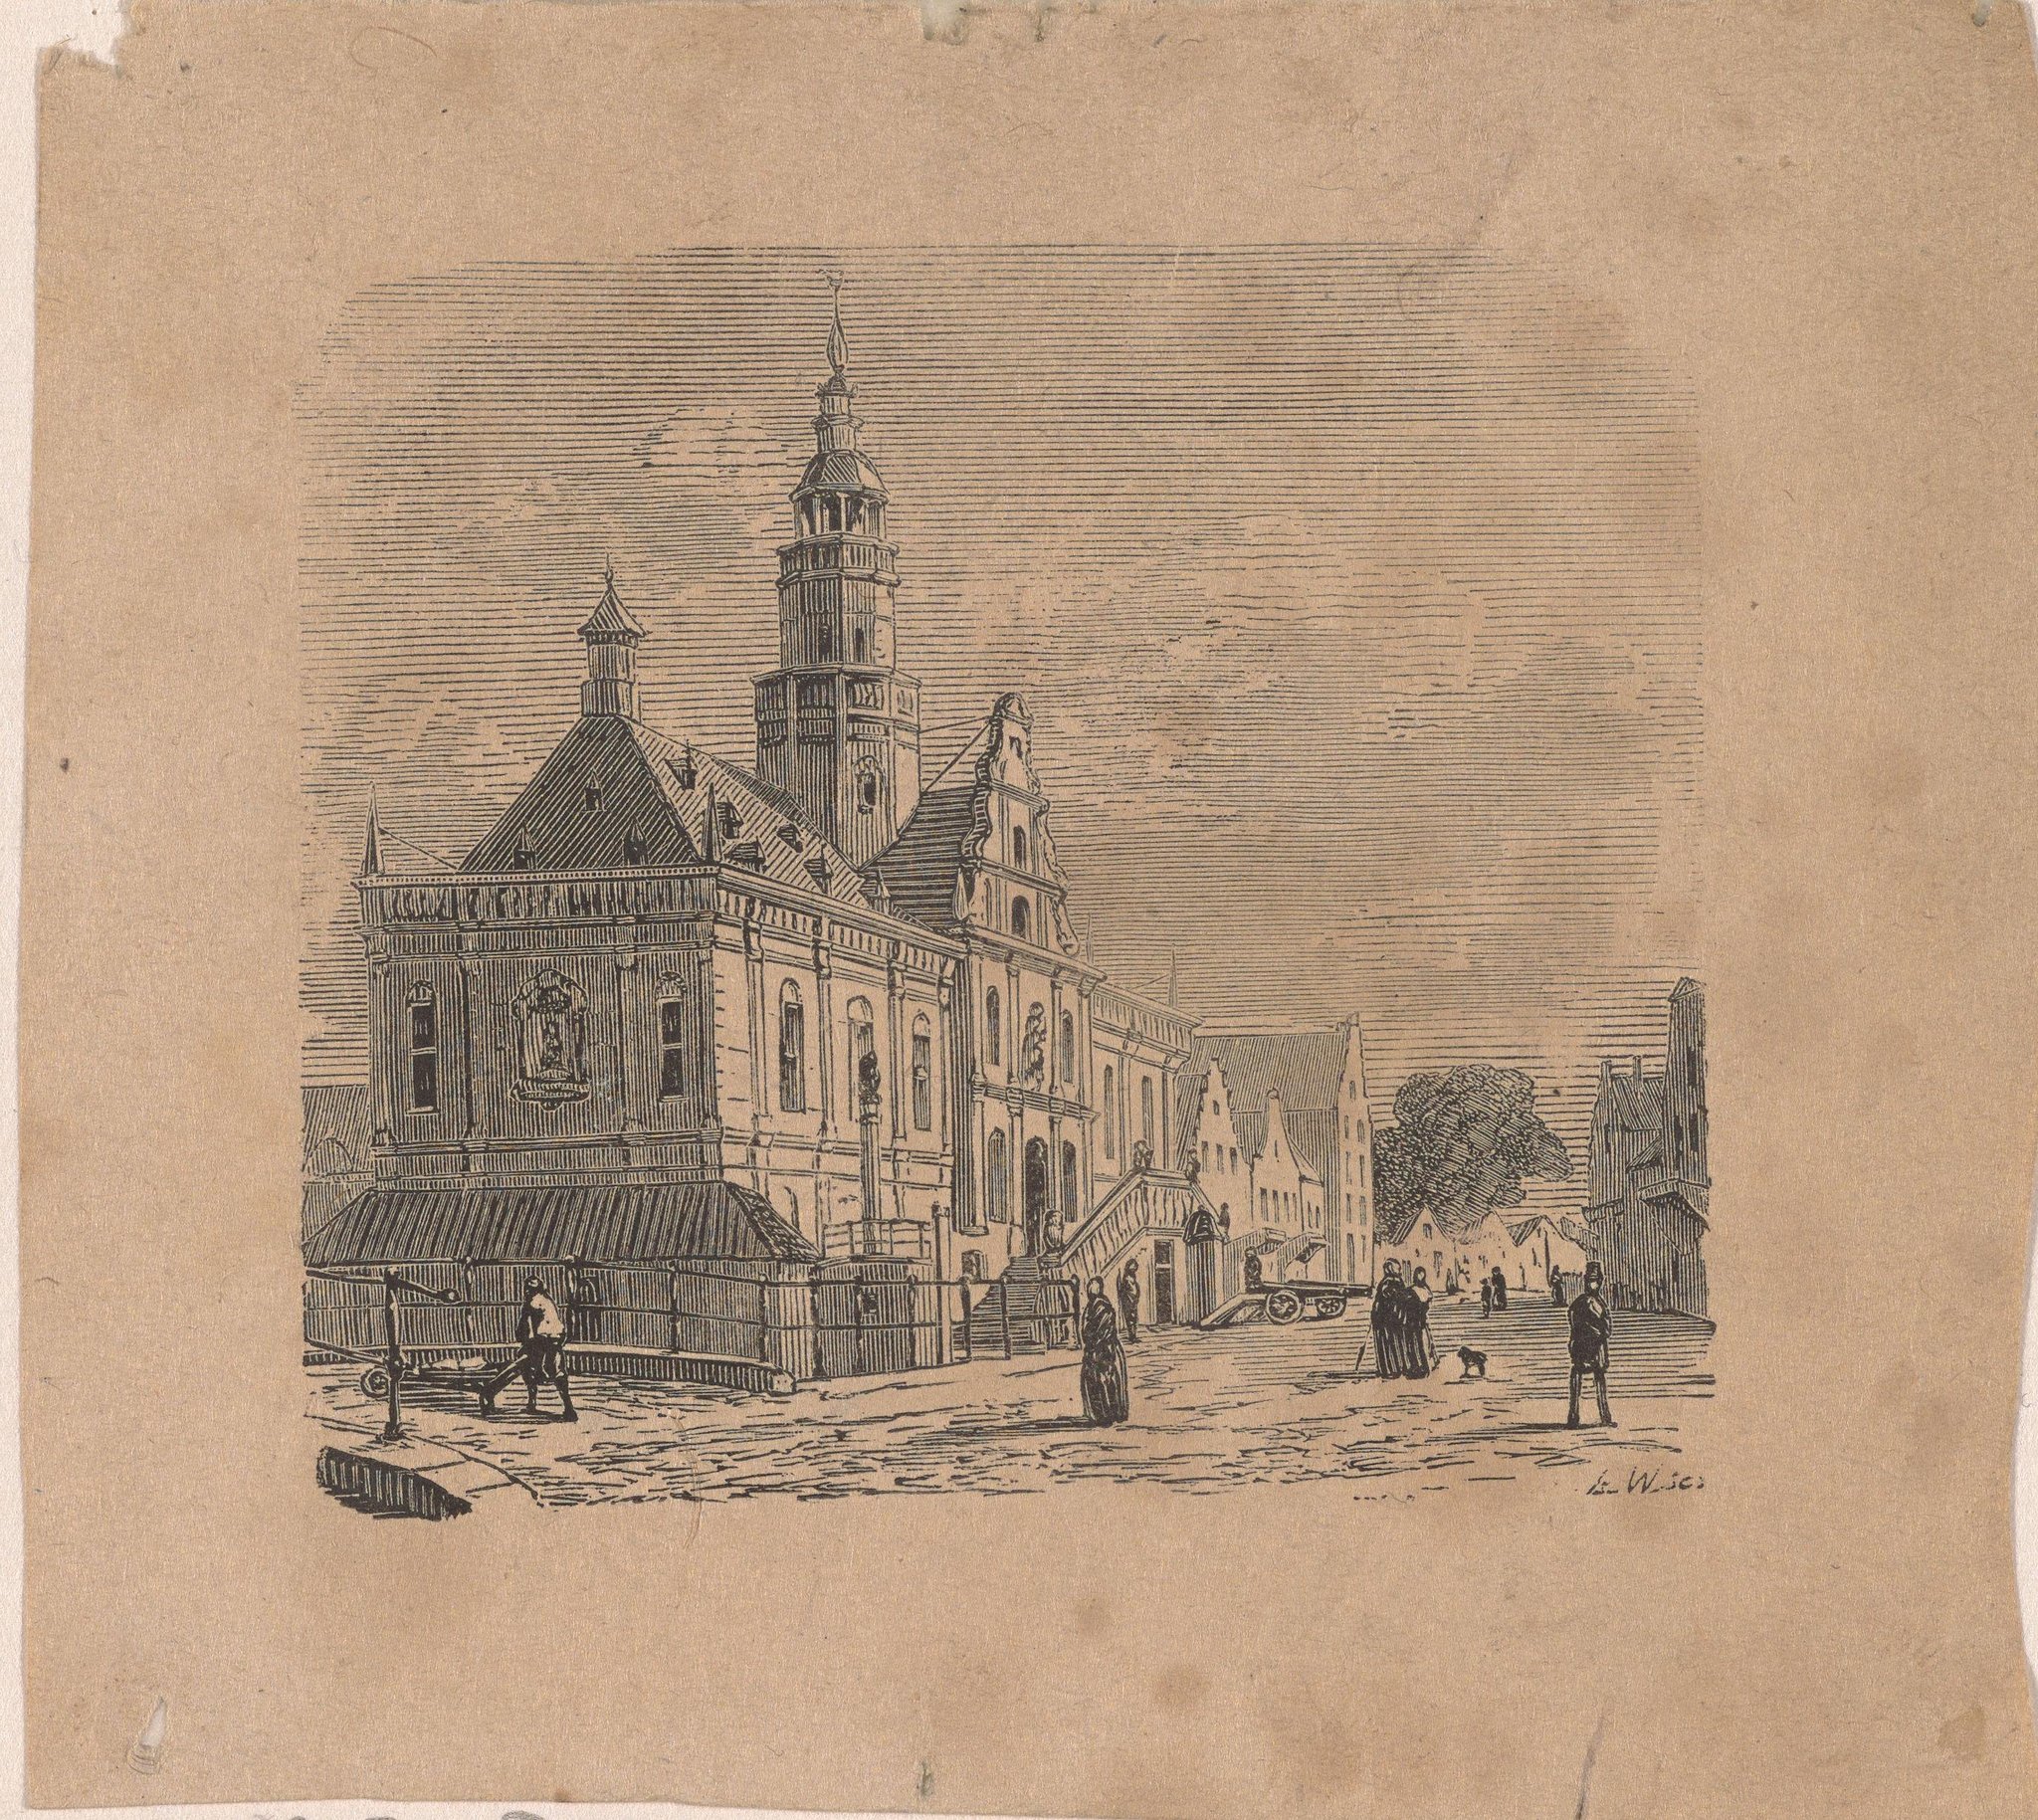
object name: print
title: Gezicht op het stadhuis te Bolsward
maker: isaac weissenbruch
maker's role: print maker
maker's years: 1826-1912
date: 1836-1912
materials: paper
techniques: engraving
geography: netherlands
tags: townhall, square, place, circus, etc. (+ city(-scape) with figures, staffage)